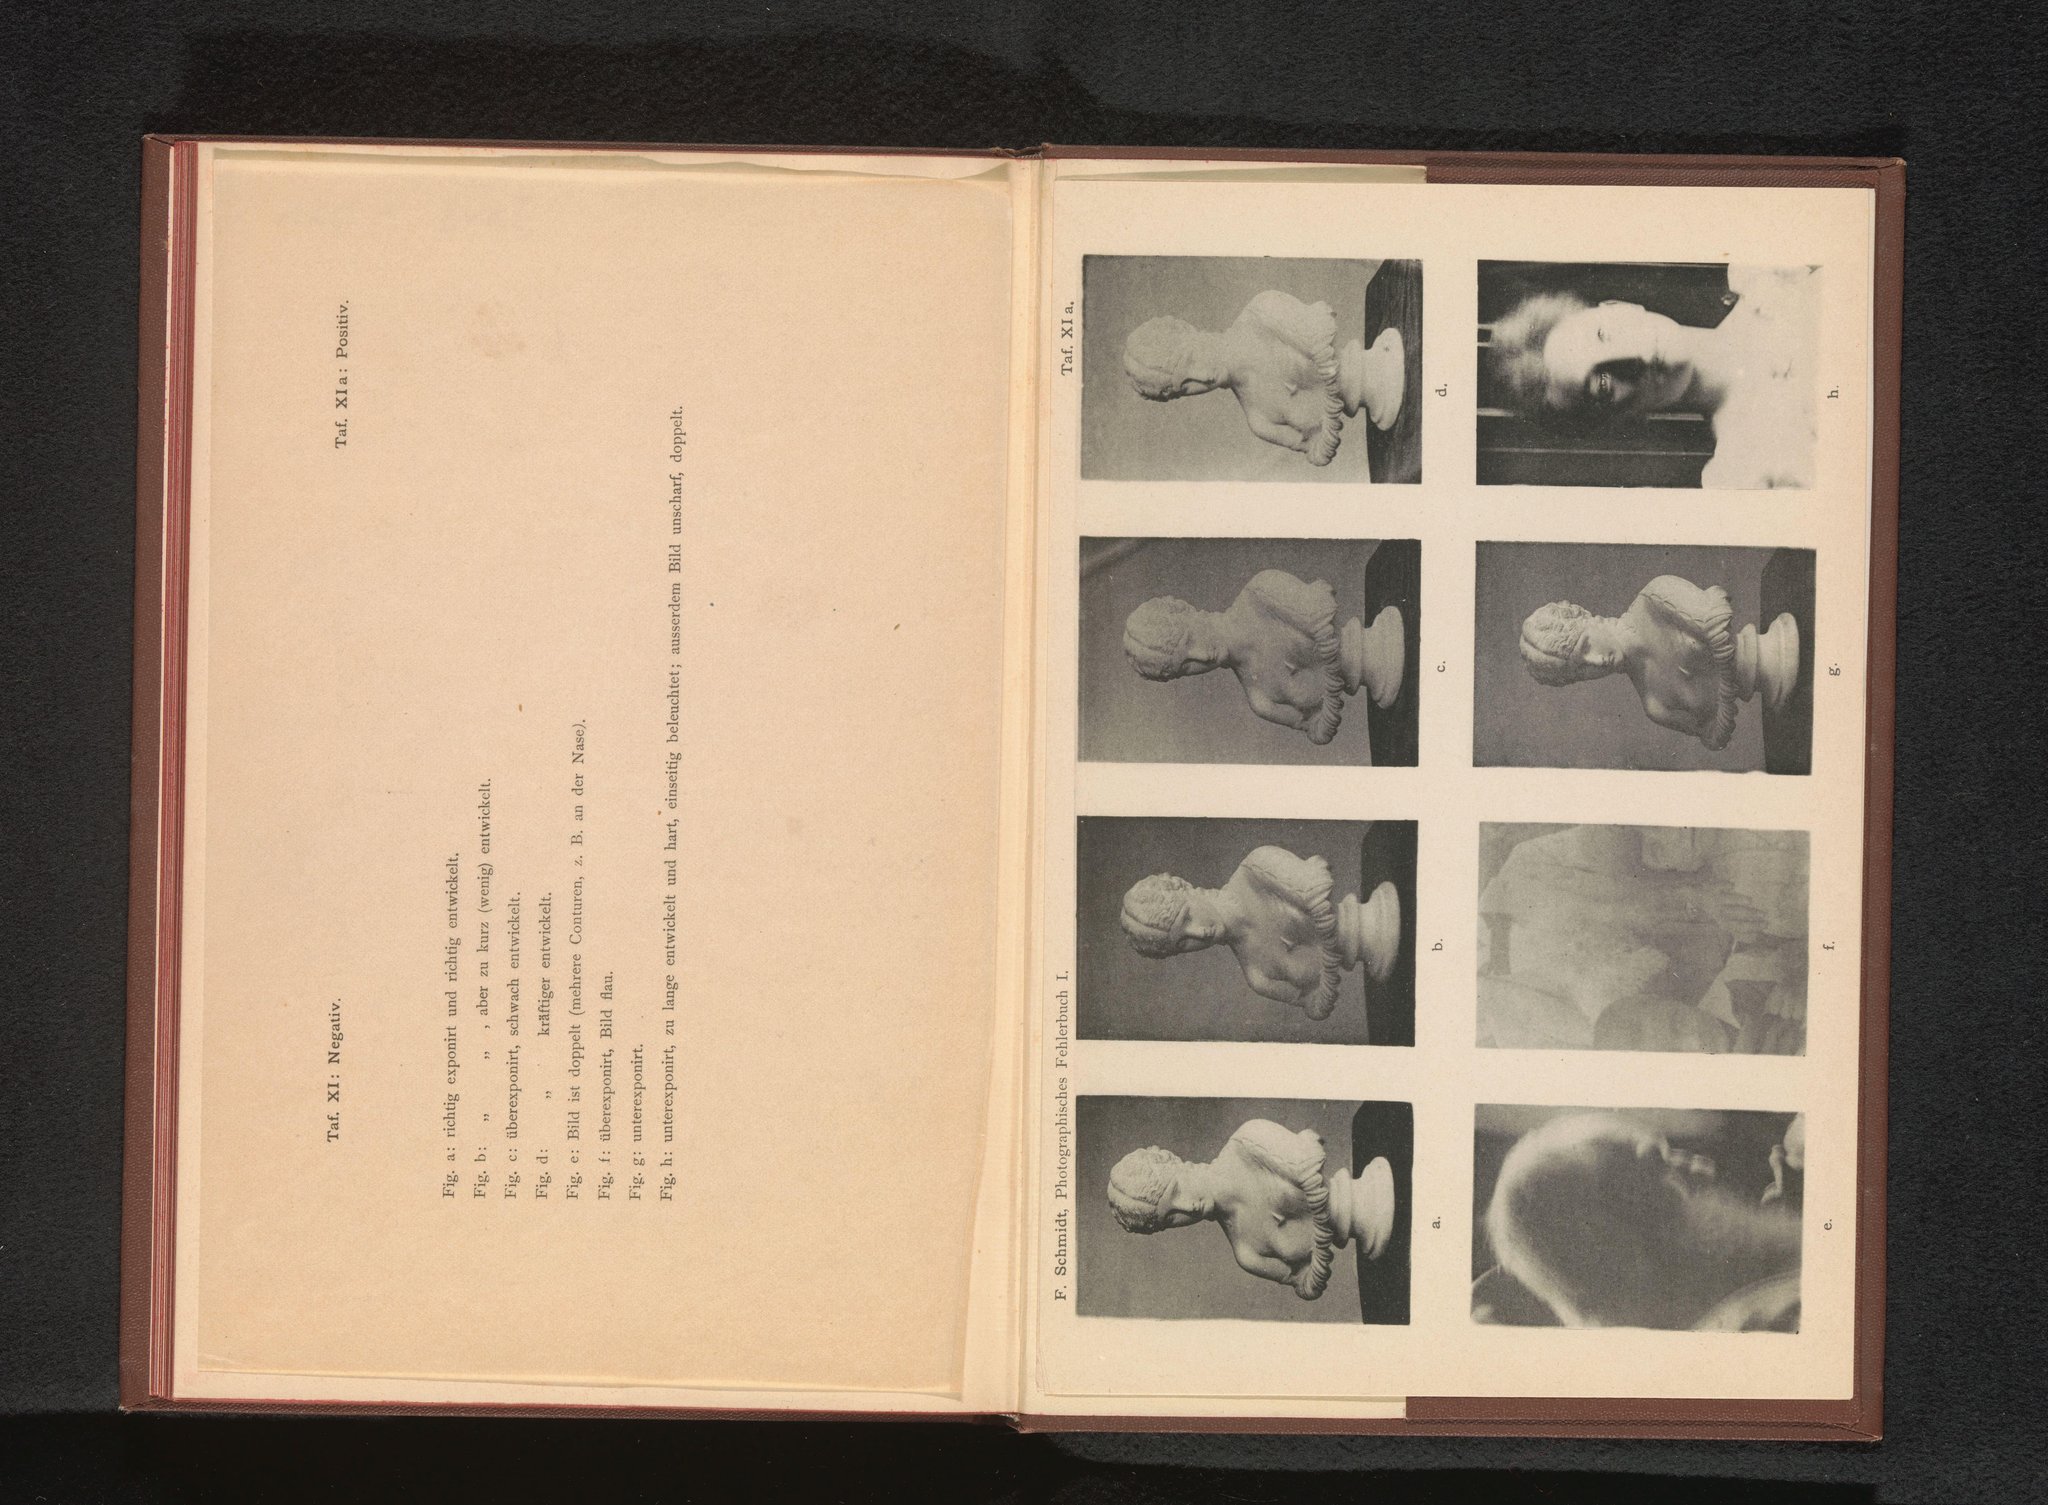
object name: page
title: Acht voorbeelden van belichtingsstudies en studies van verschillende manieren van ontwikkelen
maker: Anonymous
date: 1890-1895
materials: paper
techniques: photograph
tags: adult woman, piece of sculpture, reproduction of a piece of sculpture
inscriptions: inscription: ‘a. b. c. d./ e. f. g. h.’, number: ‘Taf. XI a.’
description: Prenten op losse bladen. Bladen in insteekhoes achterin boek.